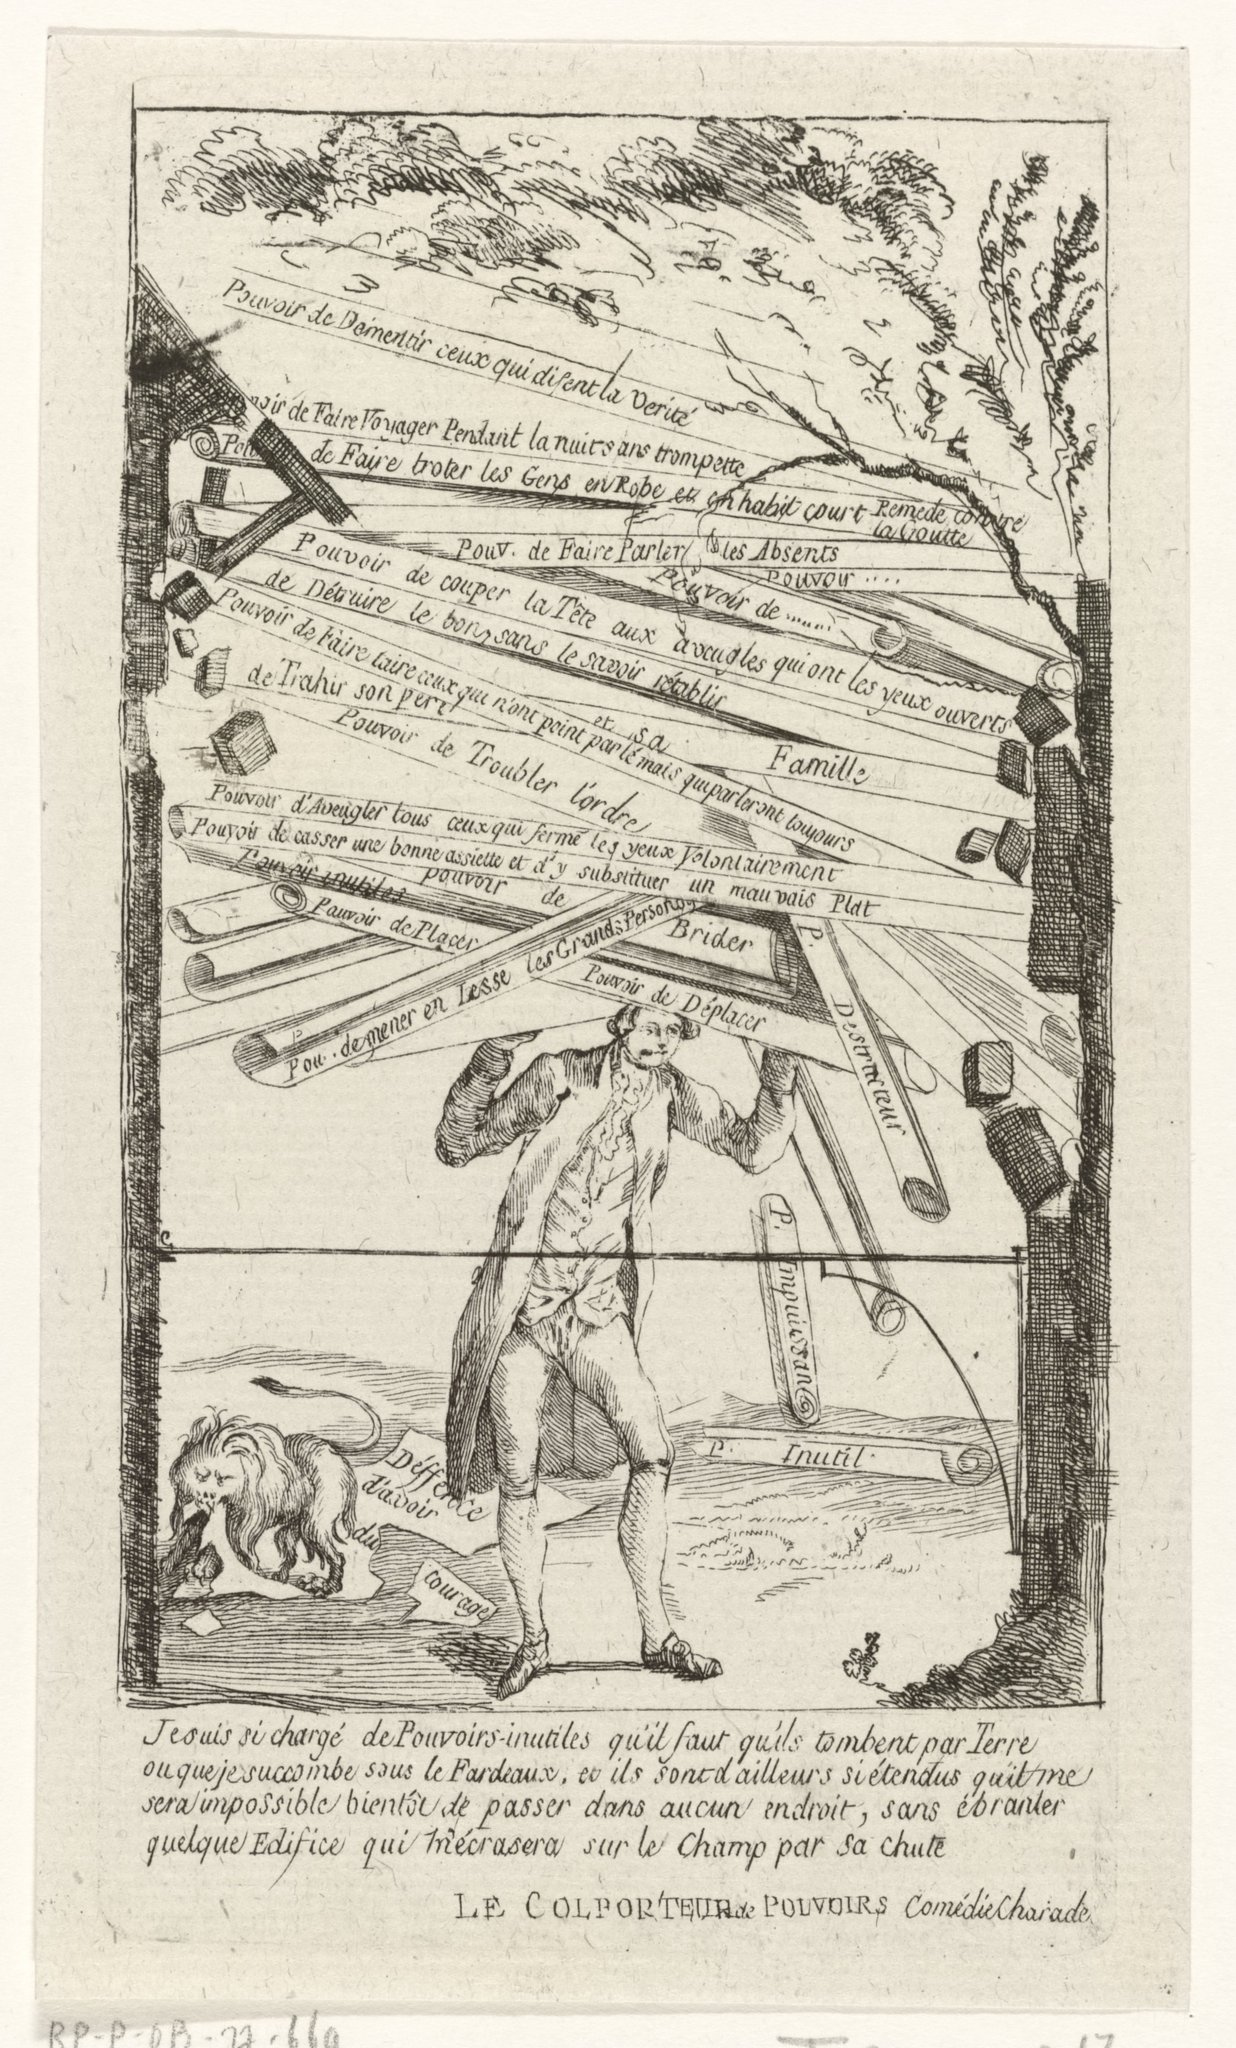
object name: cartoon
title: Man torst enorme hoeveelheid taken op zijn schouders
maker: Anonymous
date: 1788-1790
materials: paper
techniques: etching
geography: southern netherlands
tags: brabant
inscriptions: collector's mark: Lugt 2228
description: Spotprent op een man die een grote hoeveelheid documenten met taken (pouvoirs) op zijn schouders torst. Met vierreglig onderschrift in het Frans. In verband met gebeurtenissen in januari 1788. Onderdeel van een grote groep van prenten betrekking hebbend op de gebeurtenissen van de Brabantse Omwenteling en de periode 1787-1790.